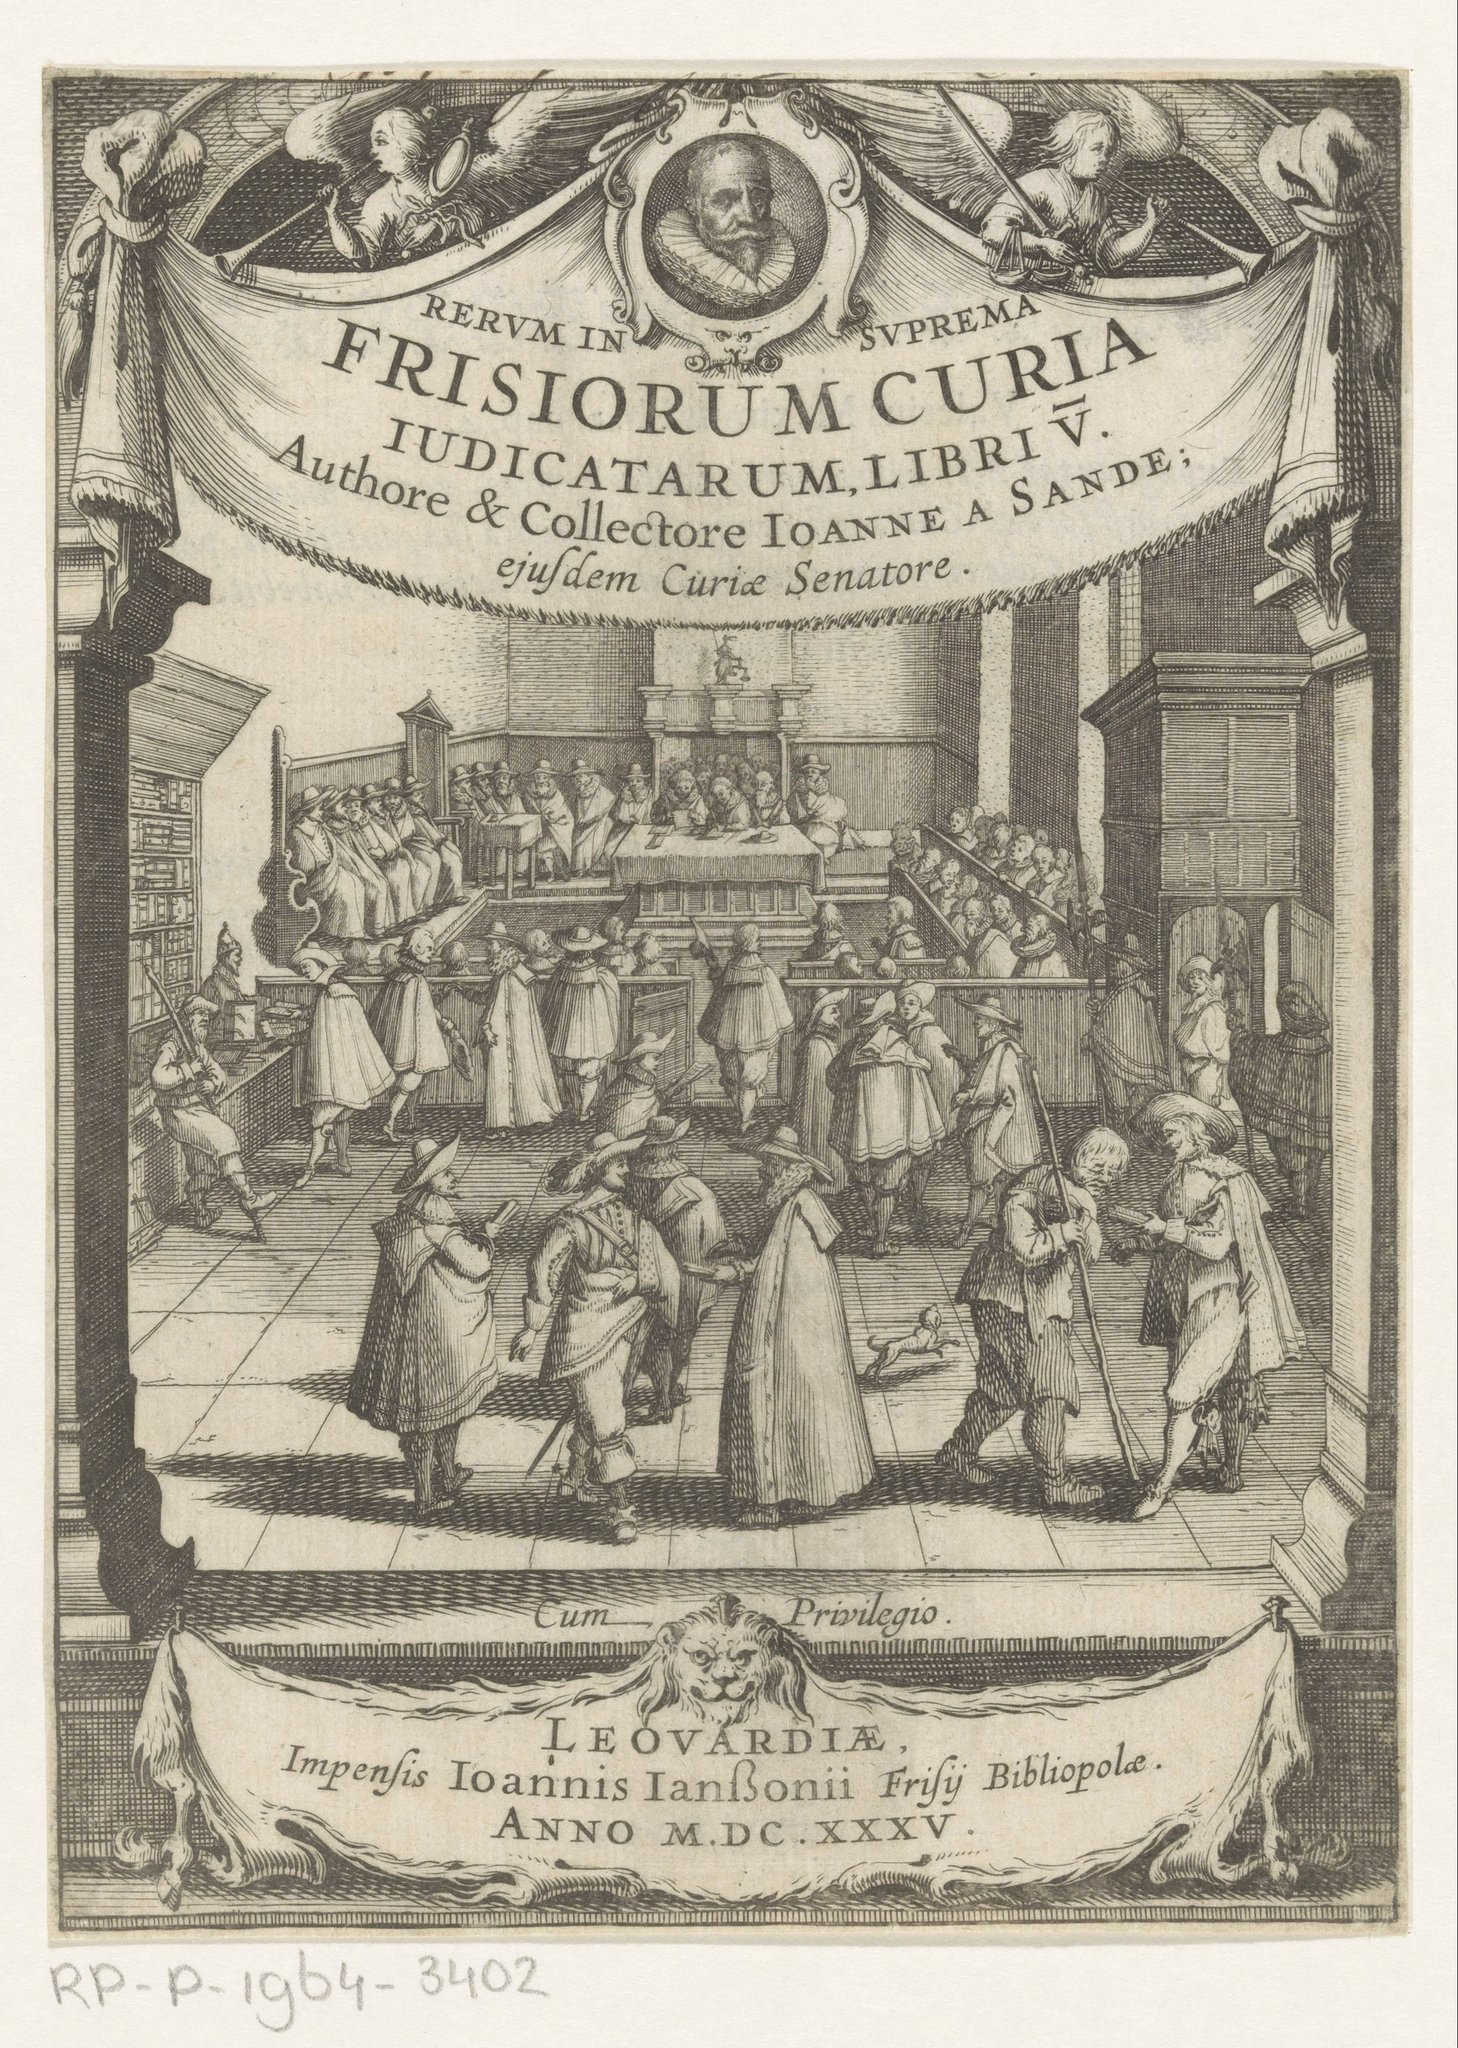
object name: print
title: Titelpagina voor: Johan van den Sande, Rerum in suprema Frisiorum curia iudicatarum, libri V, 1635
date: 1635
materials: paper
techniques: engraving, letterpress printing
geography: leeuwarden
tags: law and jurisprudence (+ court room), symbols and allegories of jurisprudence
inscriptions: collector's mark: Lugt 2228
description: Vele mannelijke figuren in een interieur van een rechtbank. Aan weerszijden van de voorstelling twee zuilen met daarboven de titel en een portret van de schrijver naar rechts binnen een cartouche. Daarboven twee engelen met de attributen van de waarheid en de rechtvaardigheid: een spiegel, respectievelijk een weegschaal en een zwaard. Onder de voorstelling een gespreide leeuwenhuid met daarop het impressum.